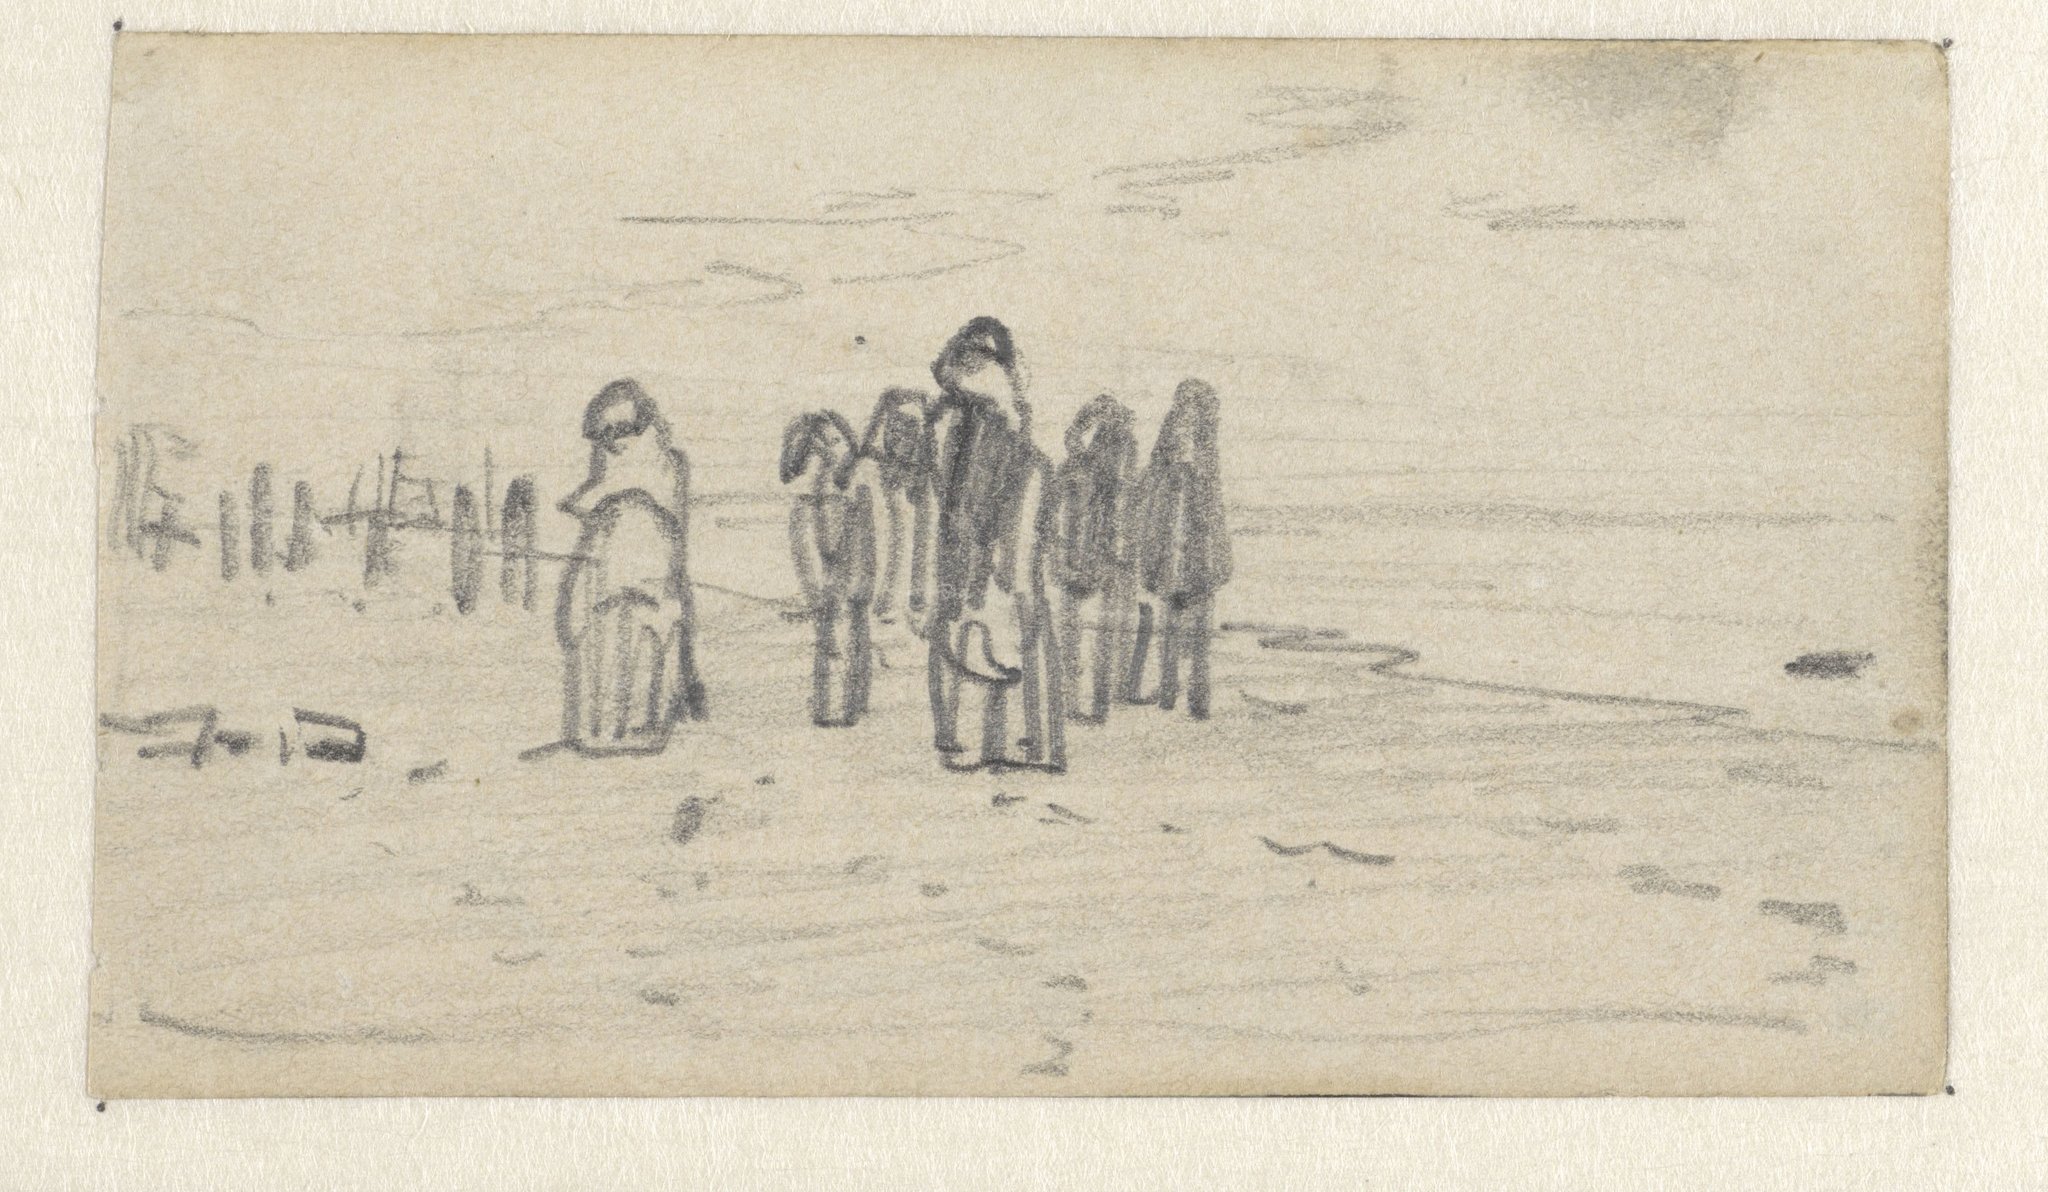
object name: drawing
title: Figuren op het strand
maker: anton mauve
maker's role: draughtsman, painter, print maker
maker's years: 1838-1888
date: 1848-1888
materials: paper, pencil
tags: beach